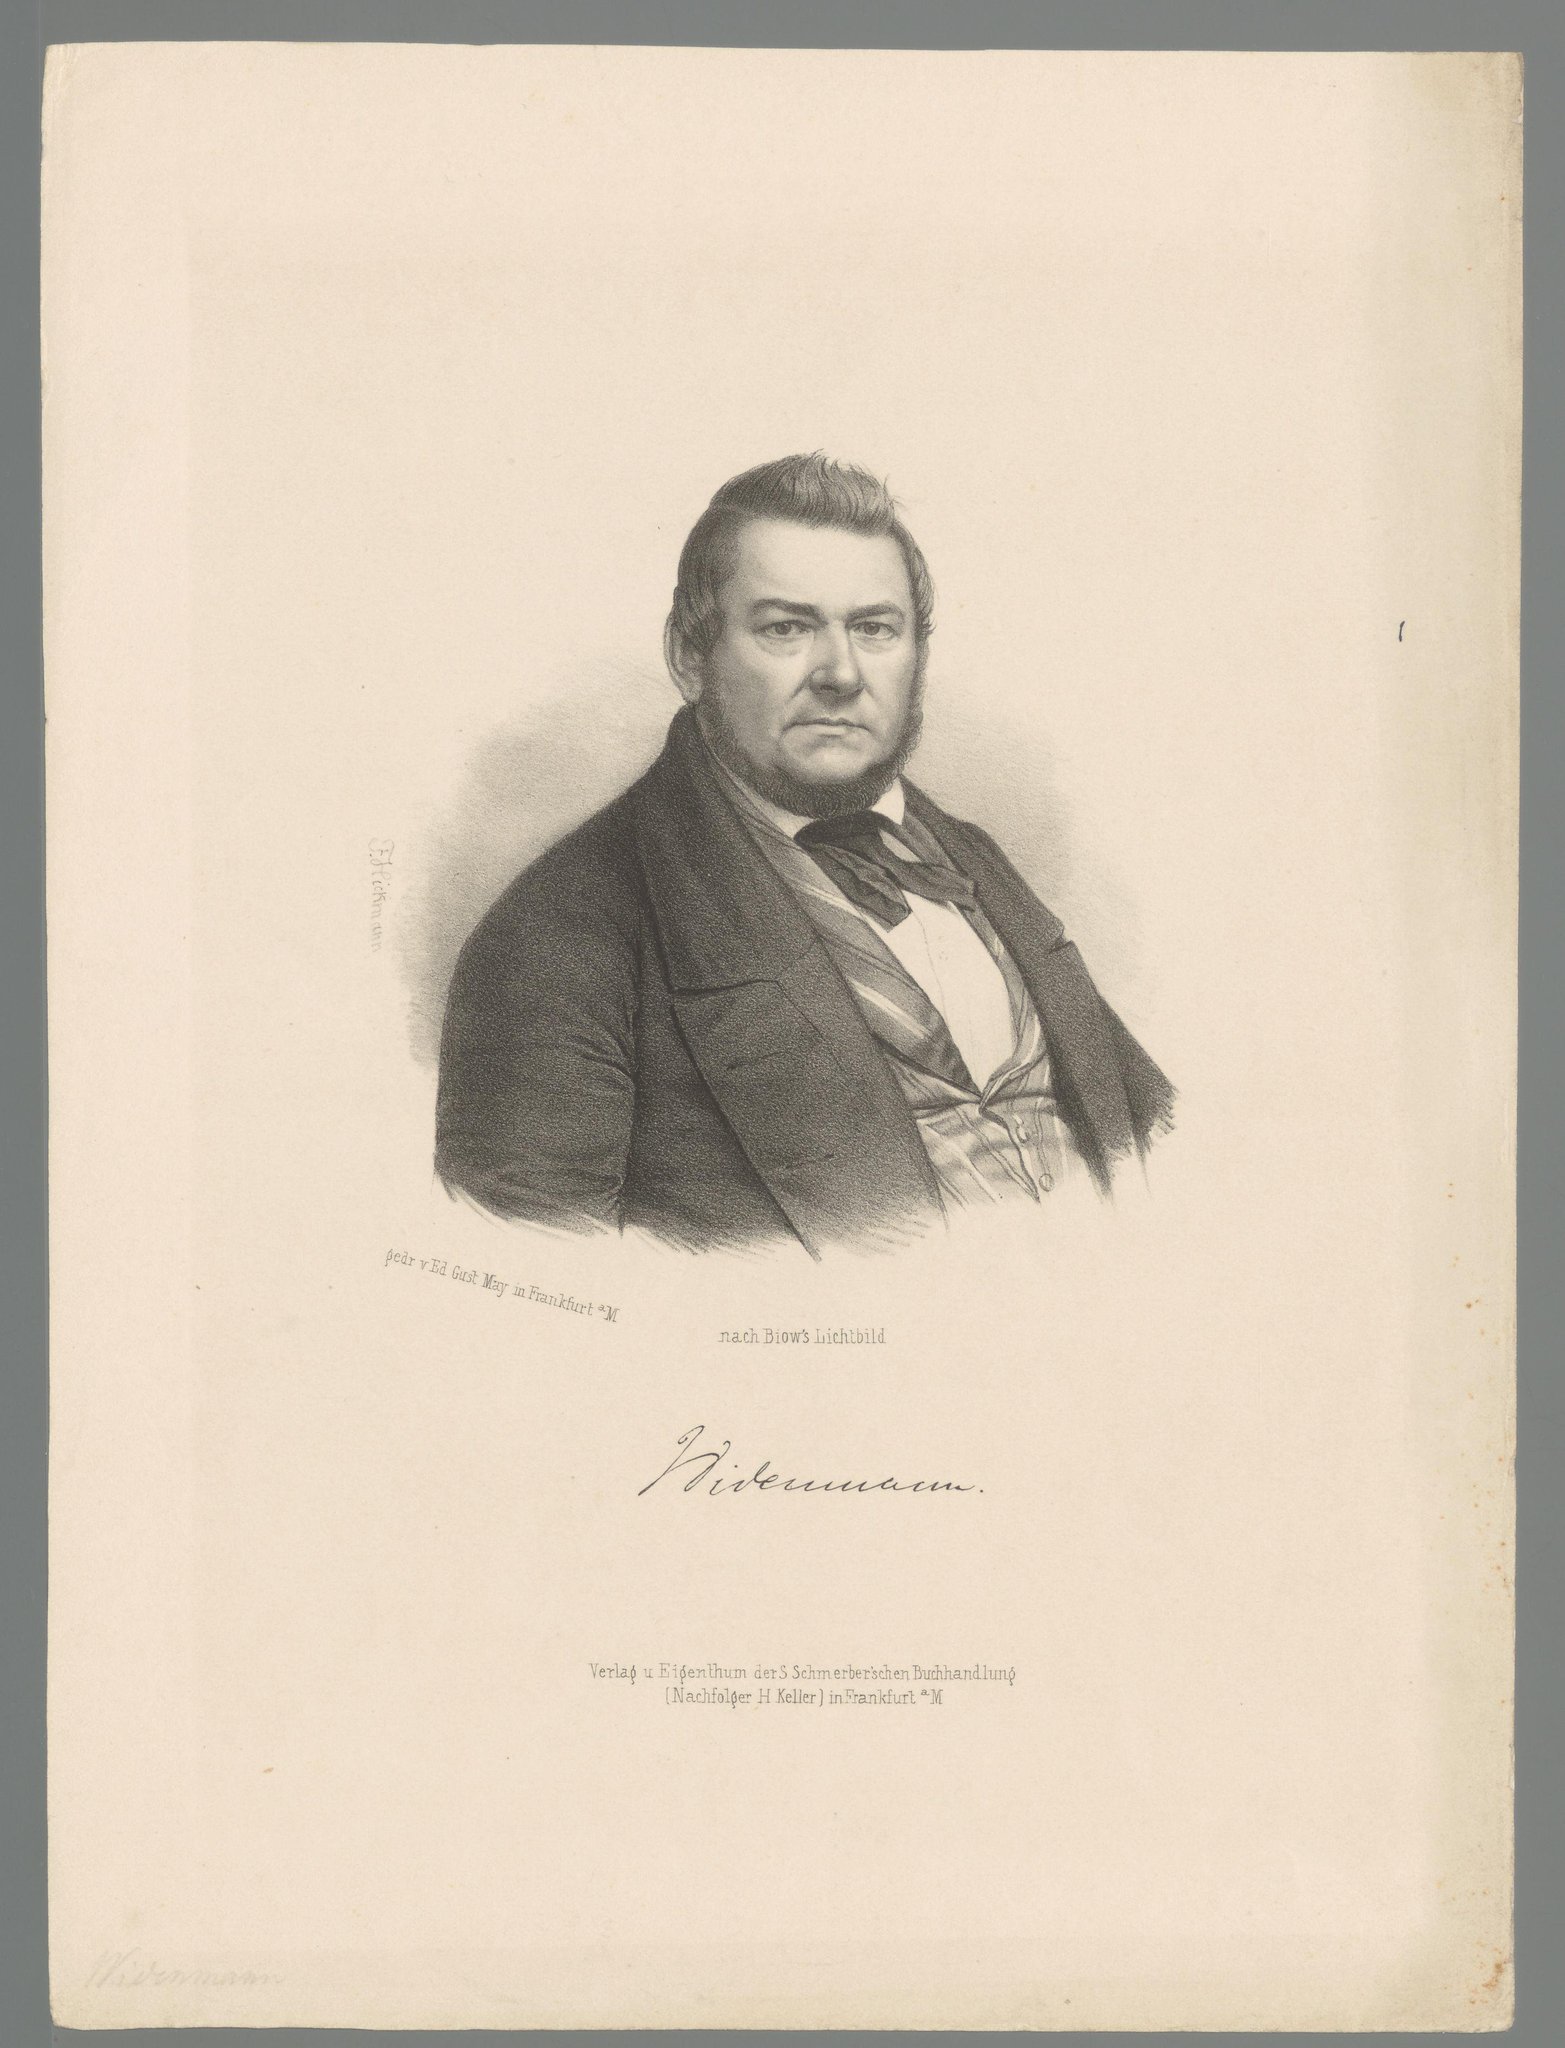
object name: print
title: Portret van Christian Widenmann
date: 1830-1900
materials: paper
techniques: lithograph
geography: frankfurt am main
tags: historical persons, politician, e.g. party leader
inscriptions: collector's mark: Lugt 2228